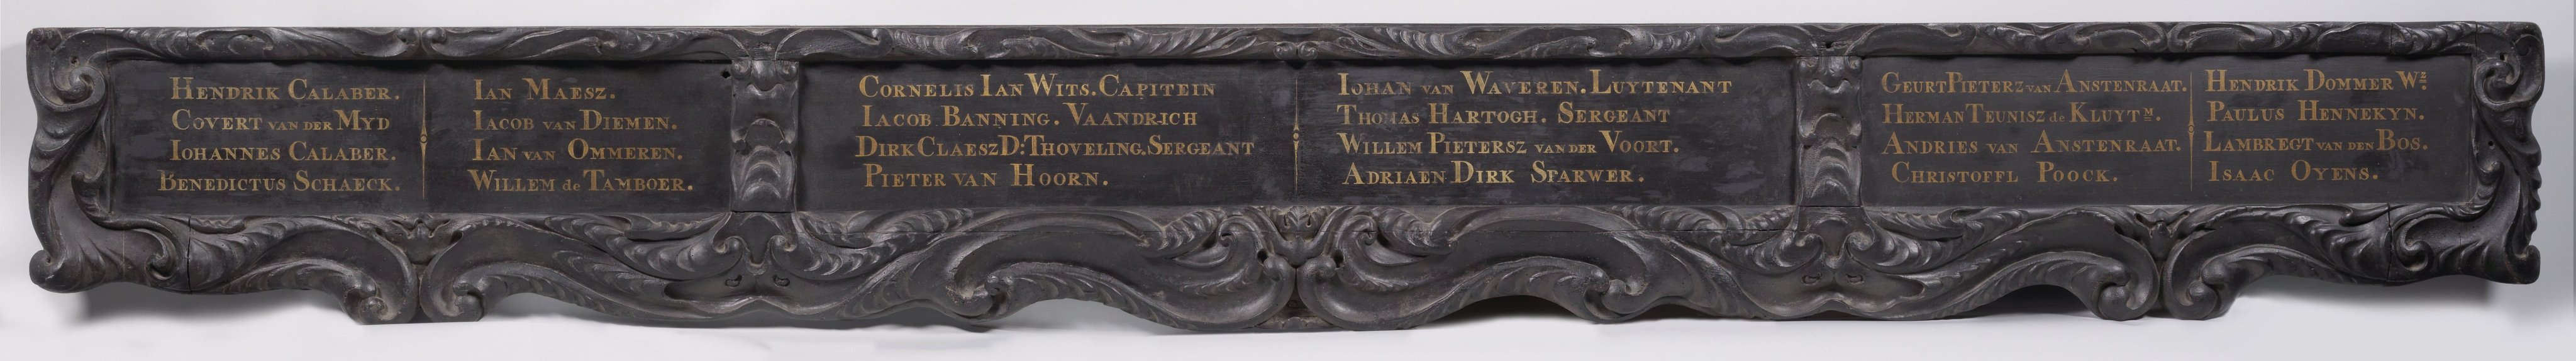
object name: nameplate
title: Naamplaat behorend bij de 'Schuttersmaaltijd' van Bartholomeus van der Helst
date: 1648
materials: wood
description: De naamplaat is een rechthoekig bord van zwart geschilderd hout, met kwabmotiefomlijsting die het bord in drie compartimenten opsplitst. Op de naamplaat zijn de namen van de geportretteerden op de Schuttersmaaltijd van Bartholomeus van der Helst aangebracht (onder meer de naam van kapitein Cornelis Jan Wits en vaandrich Jacob Banning).